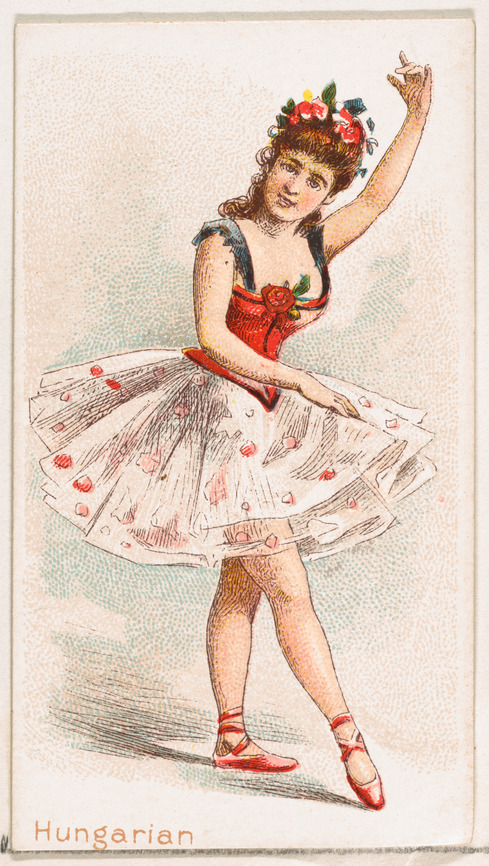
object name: print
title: Hungarian Dancer, from the Dancing Women series (N186) issued by Wm. S. Kimball & Co.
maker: william s. kimball & company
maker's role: publisher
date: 1889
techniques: color lithograph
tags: women,dancers